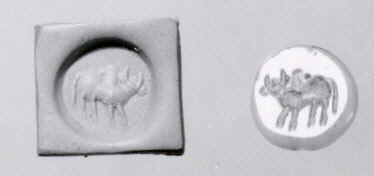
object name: stamp seal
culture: sasanian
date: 201-700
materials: quartz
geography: iran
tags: animals